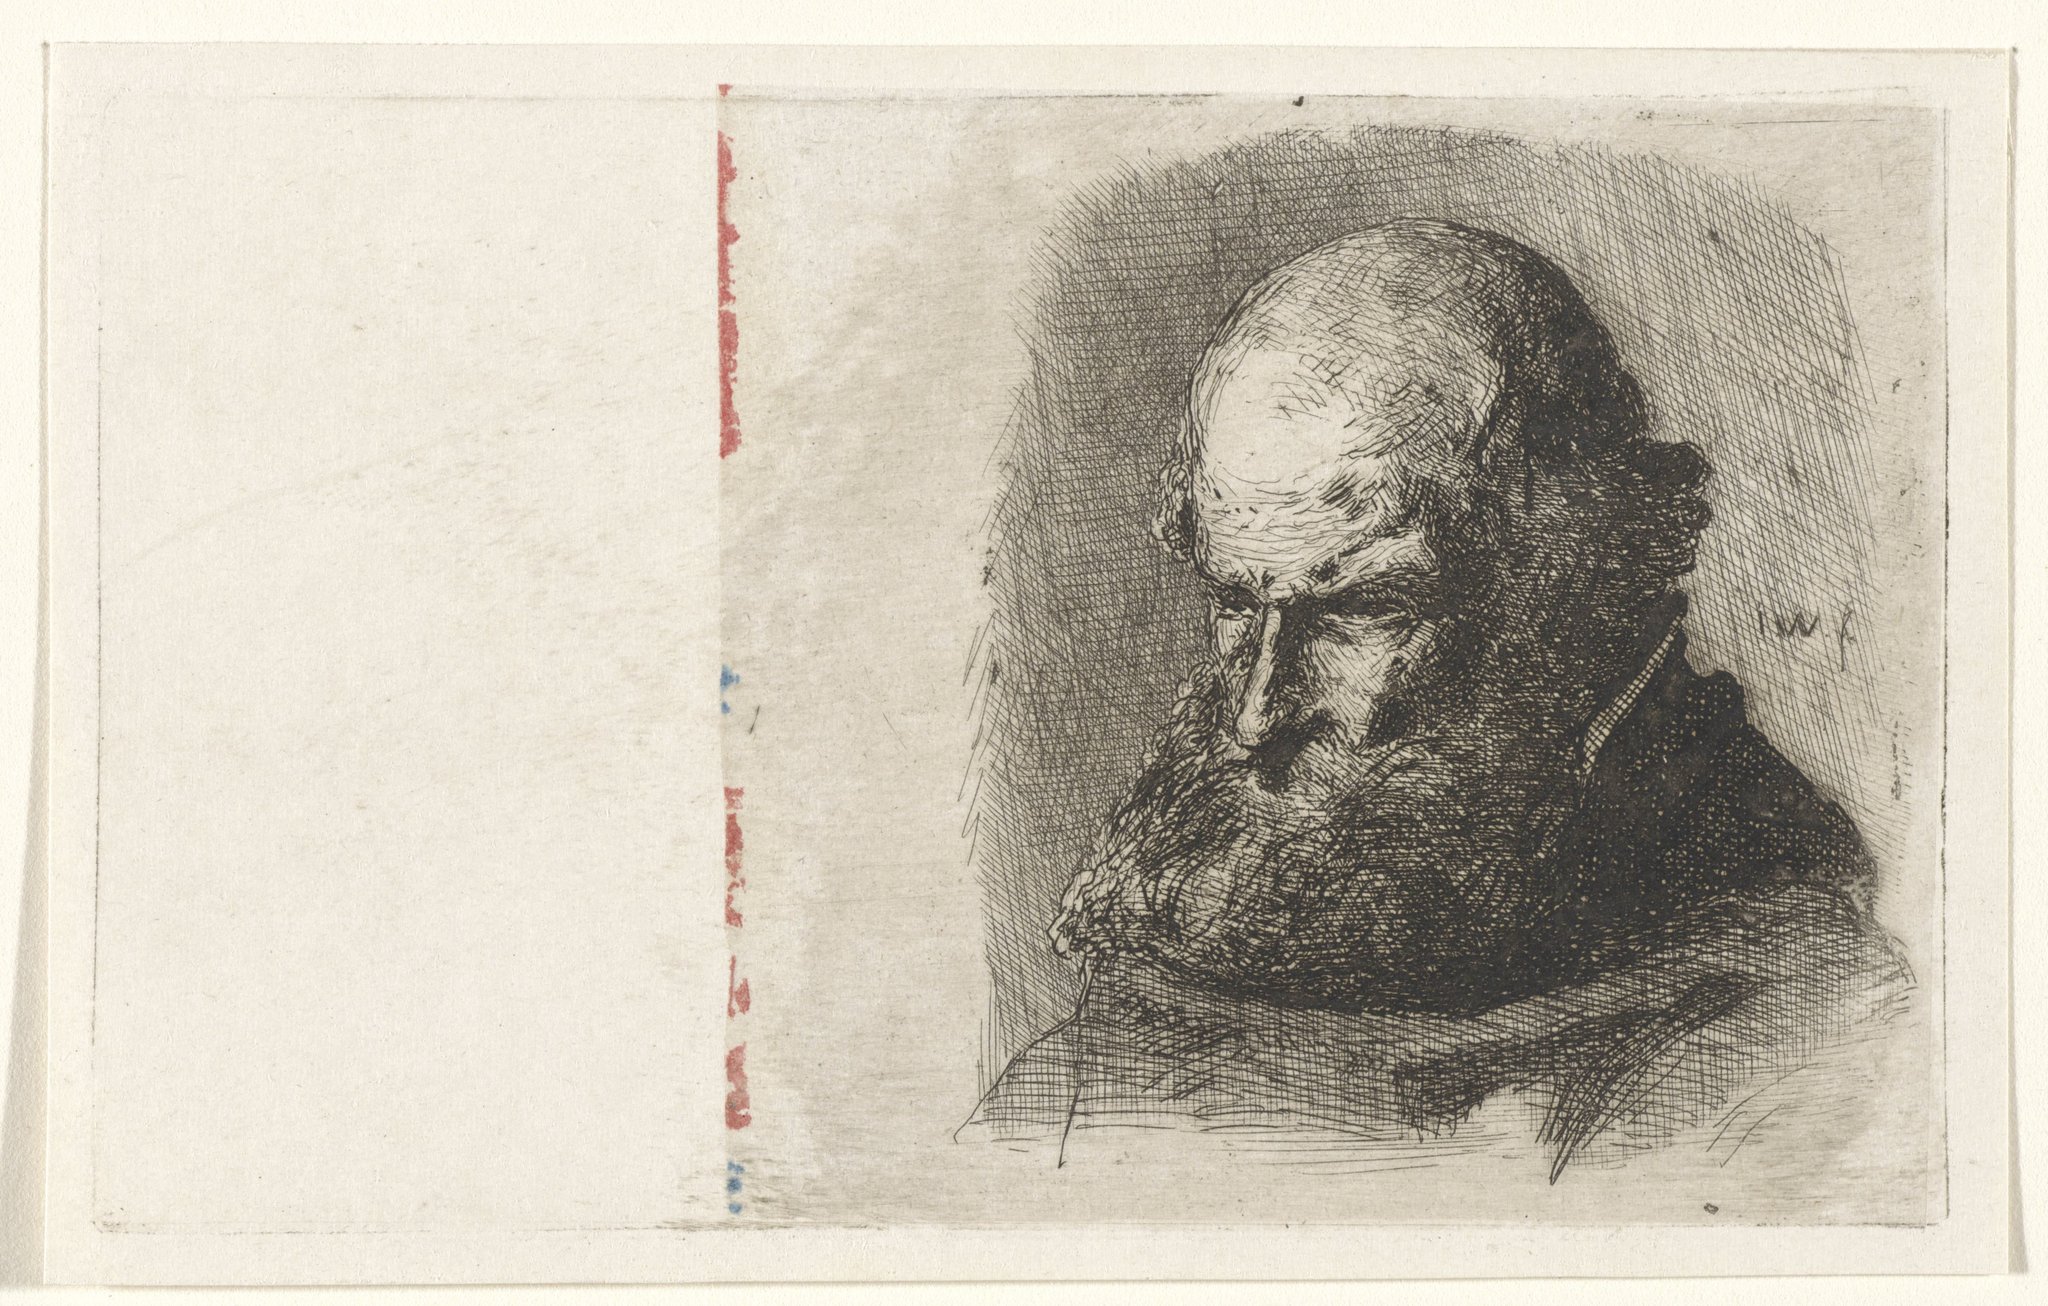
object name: print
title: Studie van een oude man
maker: jan weissenbruch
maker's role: painter, print maker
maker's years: 1822-1880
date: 1837-1880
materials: paper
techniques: etching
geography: the hague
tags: habit, frock, monk(s), friar(s), old man, beard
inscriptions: collector's mark: Lugt 2228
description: Studie van een bebaarde oude man, mogelijk een monnik in een habijt.